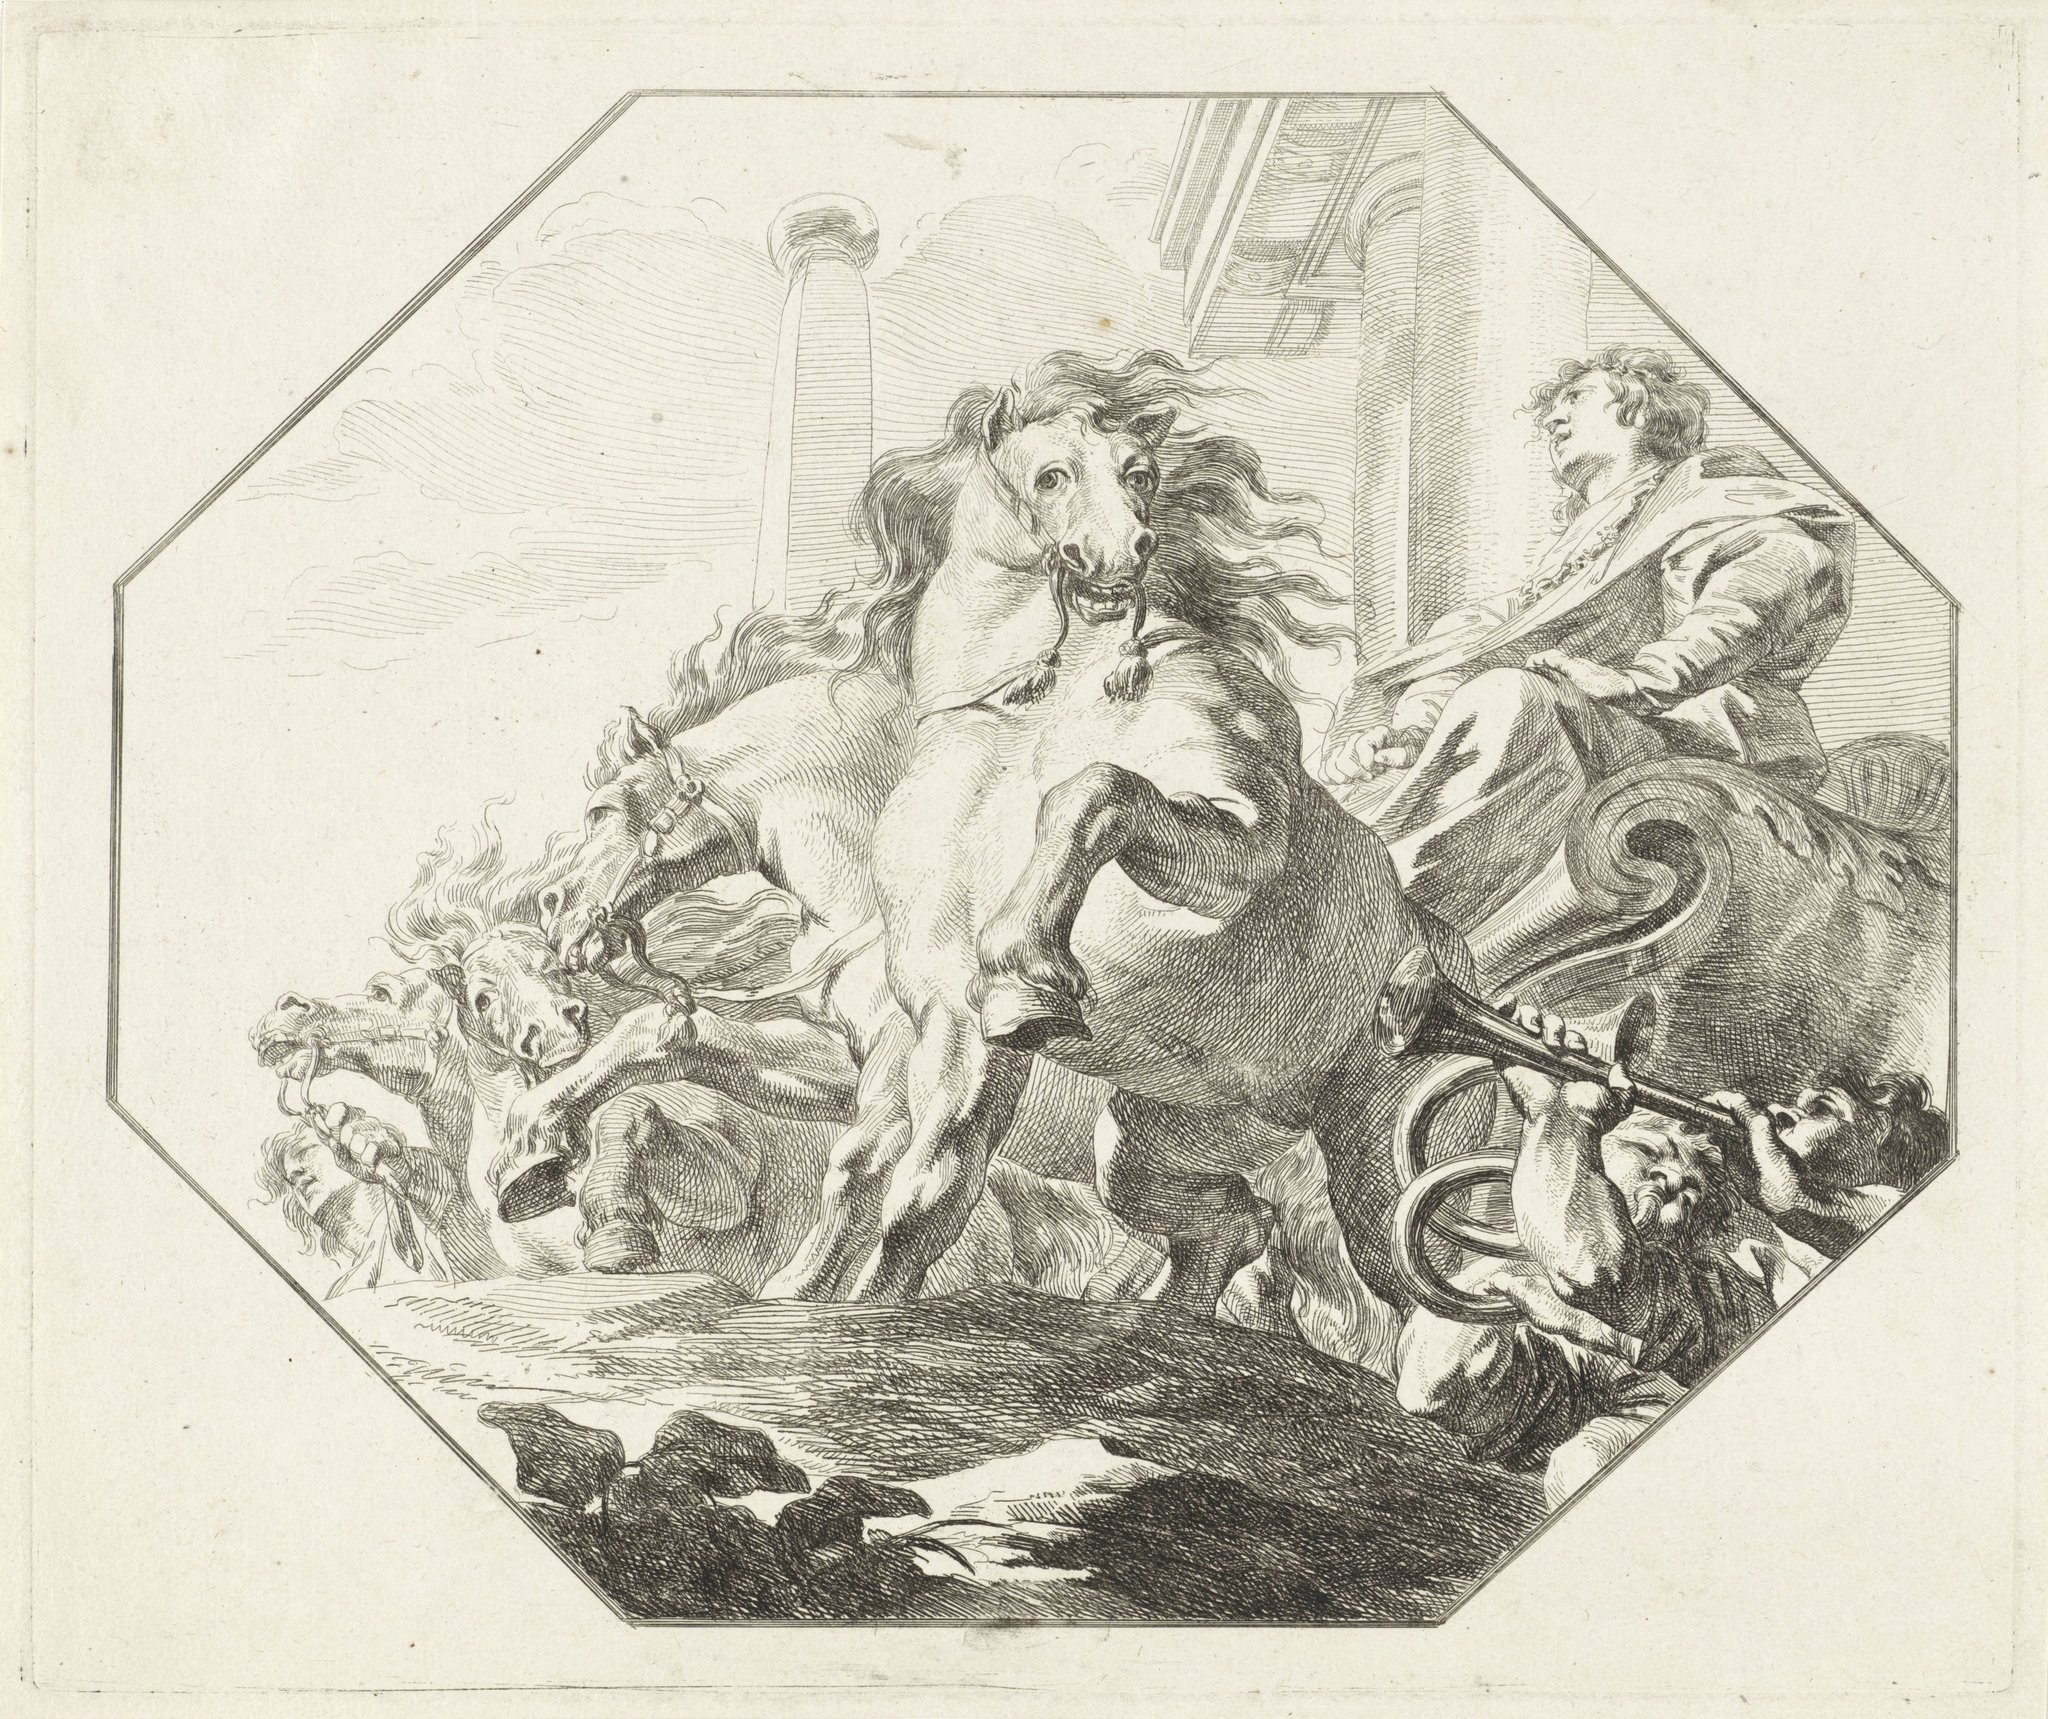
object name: print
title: Jozef in de zegewagen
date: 1705-1754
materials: paper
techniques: etching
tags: triumph of joseph: dressed in a royal attire he rides in one of pharaoh's chariots, preceded by a herald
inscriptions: collector's mark: Lugt 2228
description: Jozef zit in de zegewagen, nadat hij door de farao aangesteld is over heel Egypte. Verbeelding van de Bijbeltekst Genesis 41:37-57.